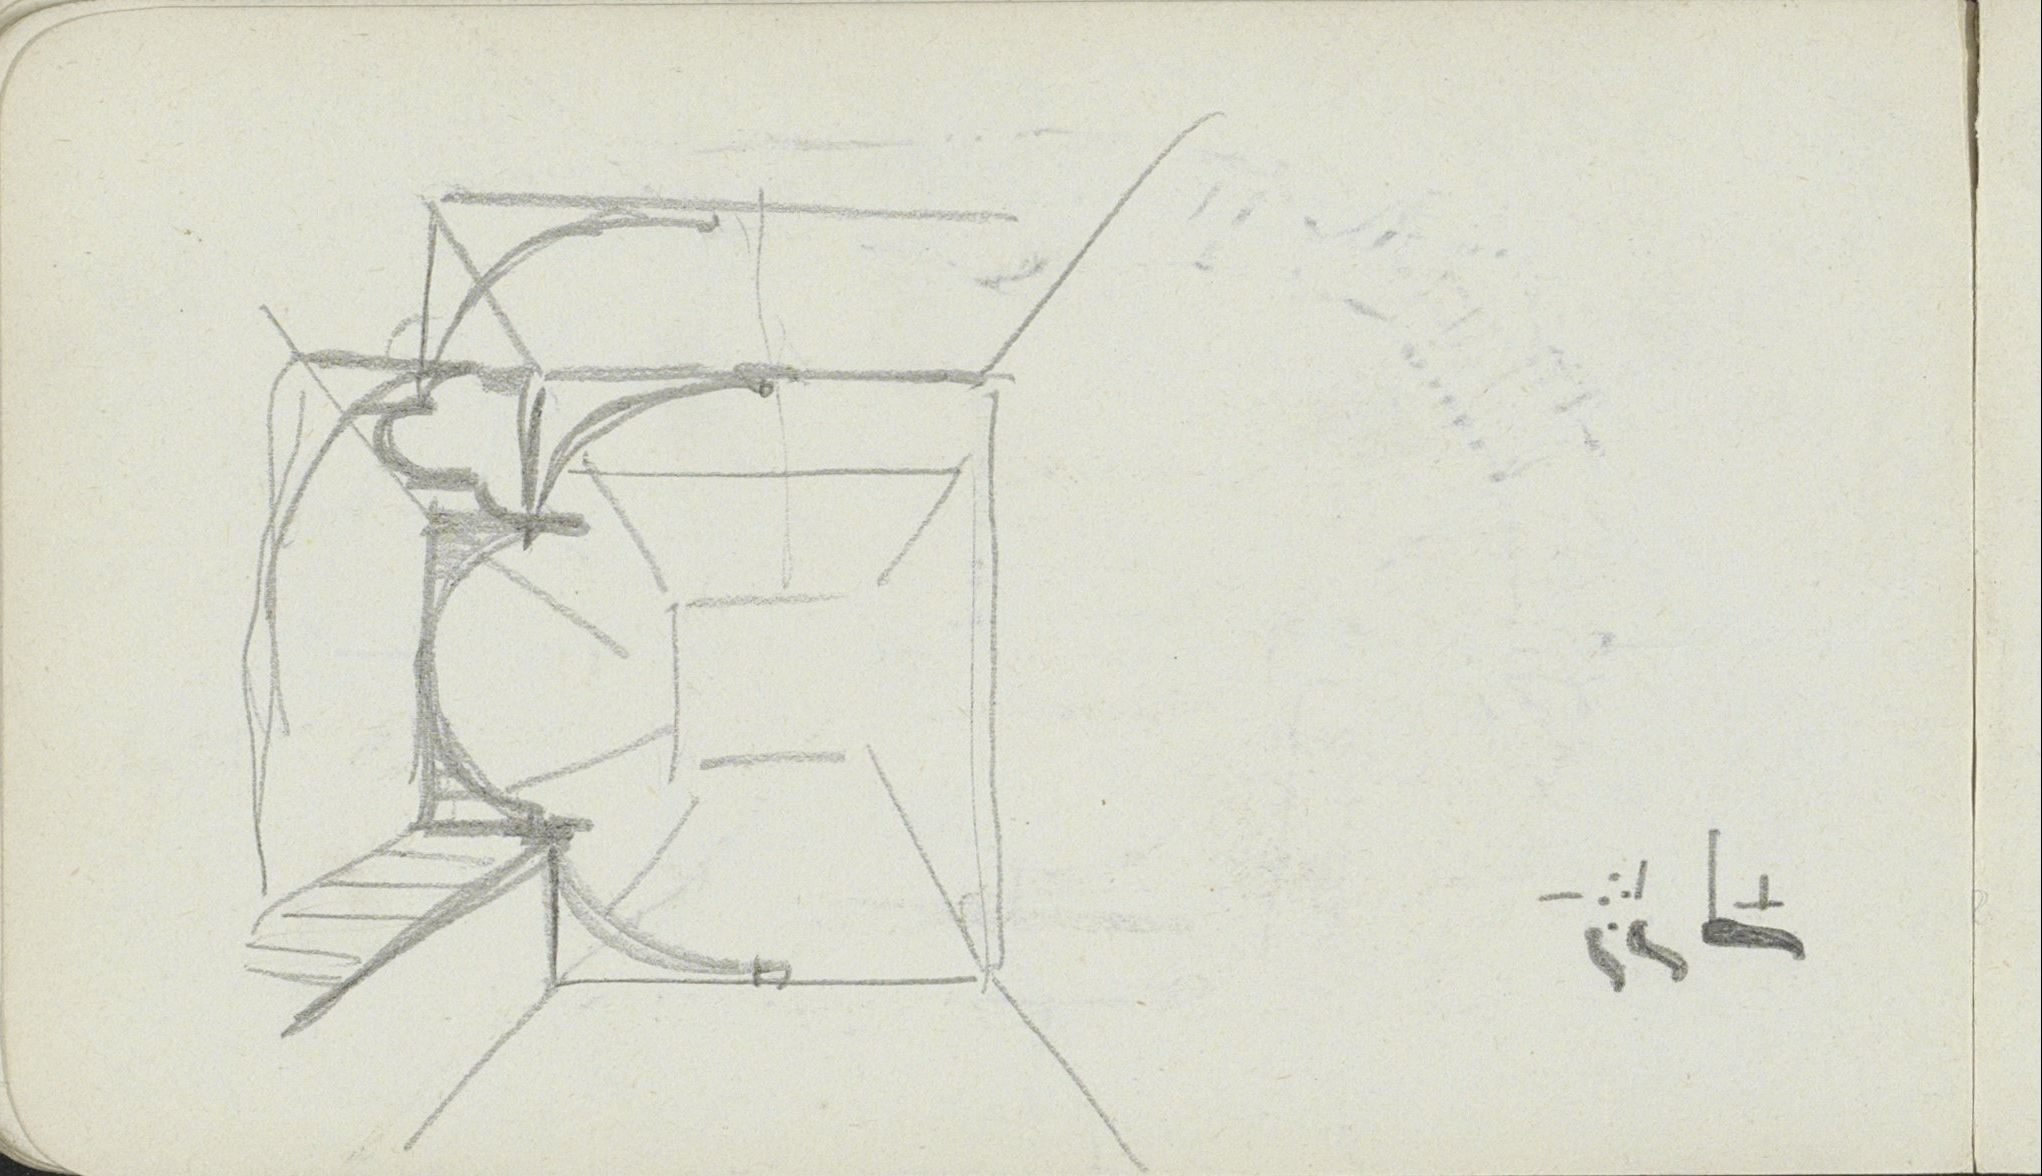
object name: sketchbook leaf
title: Gewelf in een kerkinterieur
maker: carel adolph lion cachet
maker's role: draughtsman, print maker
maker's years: 1864-1945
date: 1905-1906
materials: paper, pencil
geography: vreeland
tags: parts of church interior: vault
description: Blad 27 verso uit een schetsboek met 34 bladen.